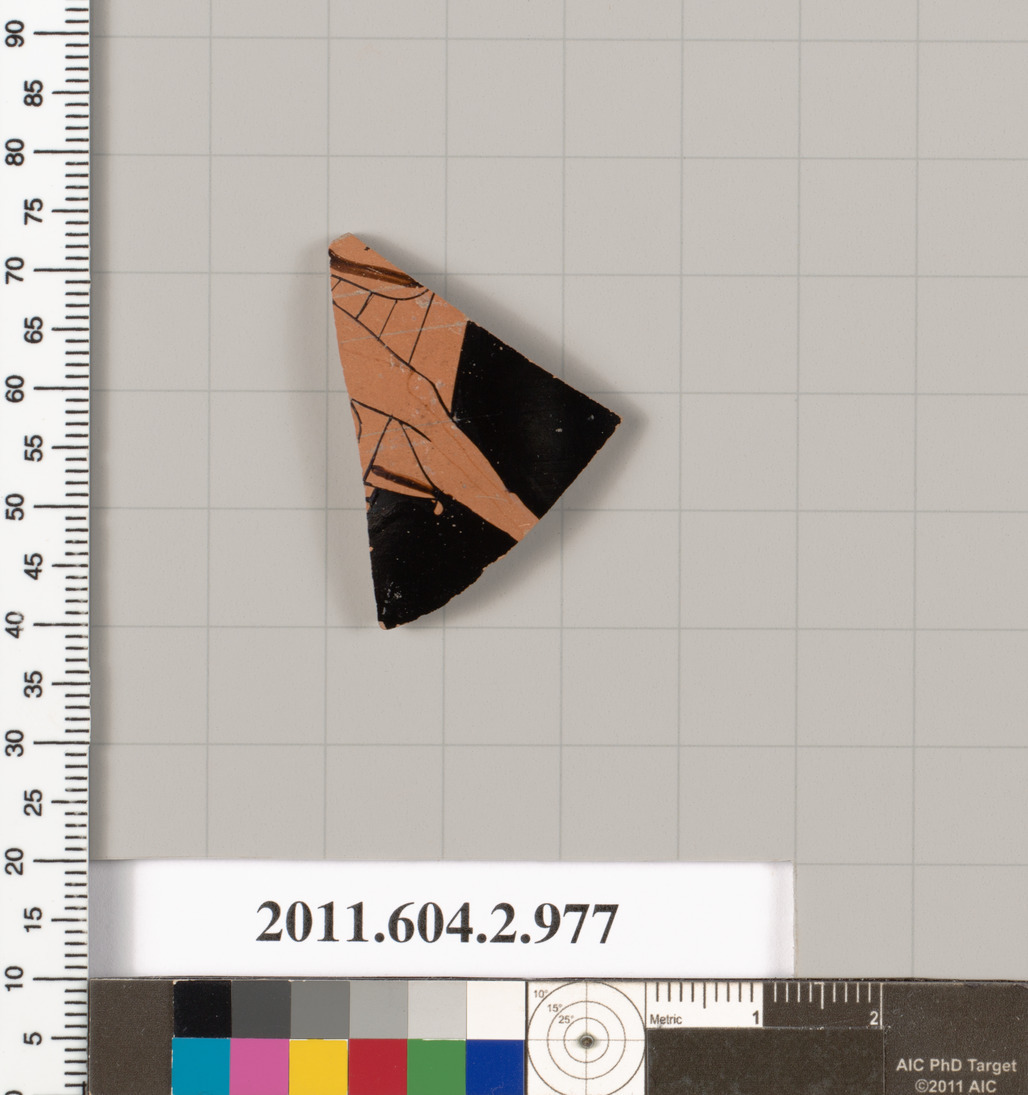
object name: oinochoe fragment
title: Terracotta fragment of an oinochoe (jug)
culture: greek, attic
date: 475-451 BCE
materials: terracotta